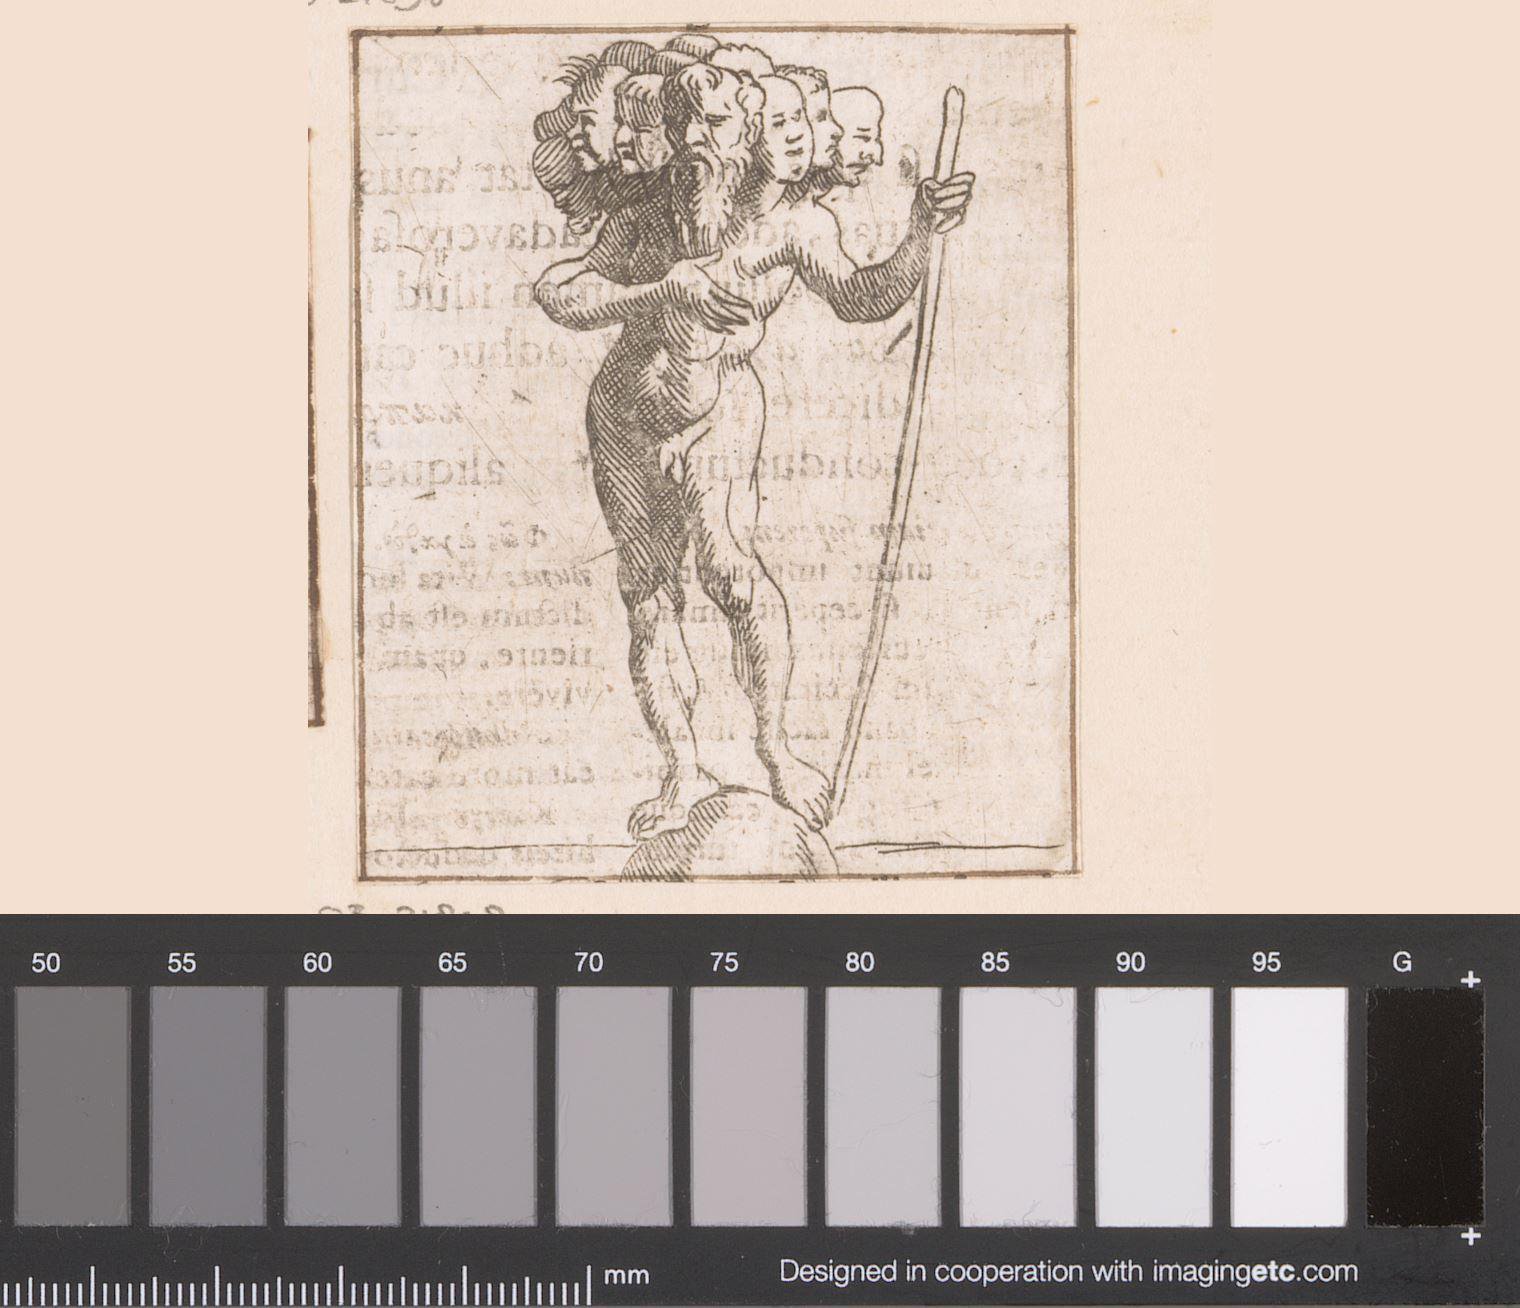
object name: print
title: Illustraties uit de Lof der Zotheid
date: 1516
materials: paper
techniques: etching, letterpress printing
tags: tetramorph: human figure with four different heads (human head, ox, eagle, lion), commoners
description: Prent afkomstig uit: Erasmus, Desiderius. Morias enkomion (...). Bazel: Johann Rudolf Genath, 1676. De prenten hierin zijn naar tekeningen die Hans en Ambrosius Holbein maakten voor de theoloog Oswald Myconius in diens uitgave van de Moriae encomium (Lof der Zotheid) van 1516.